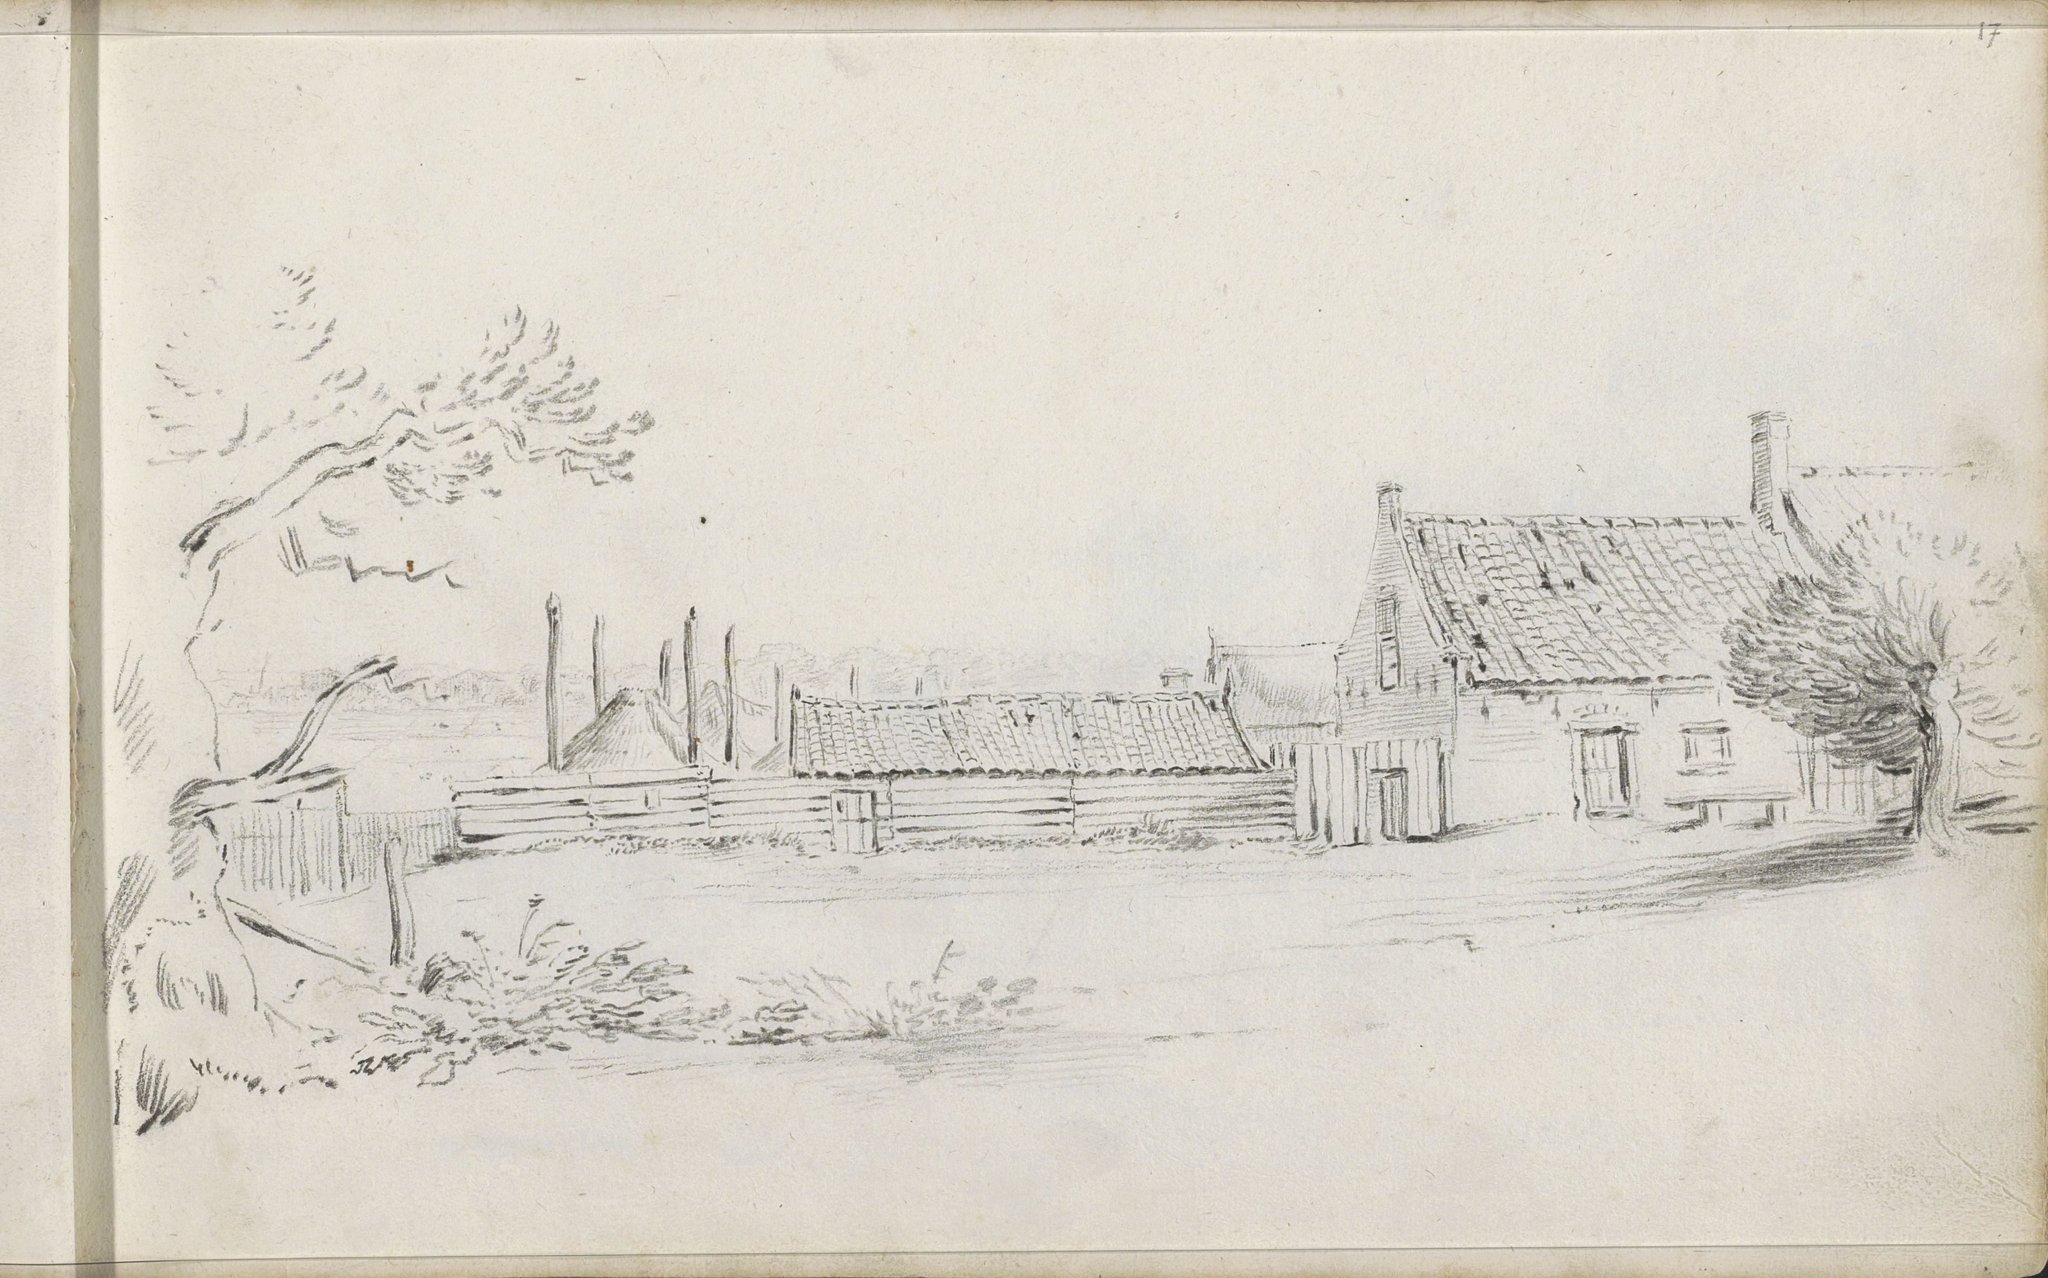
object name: sketchbook leaf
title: Boerderij met schuren en een hooimijt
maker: pieter moninckx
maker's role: draughtsman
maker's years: 1606-1686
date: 1645-1646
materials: chalk, paper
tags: barn, hay-stack, farm or solitary house in landscape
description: Blad 17 recto uit een schetsboek met 39 bladen.